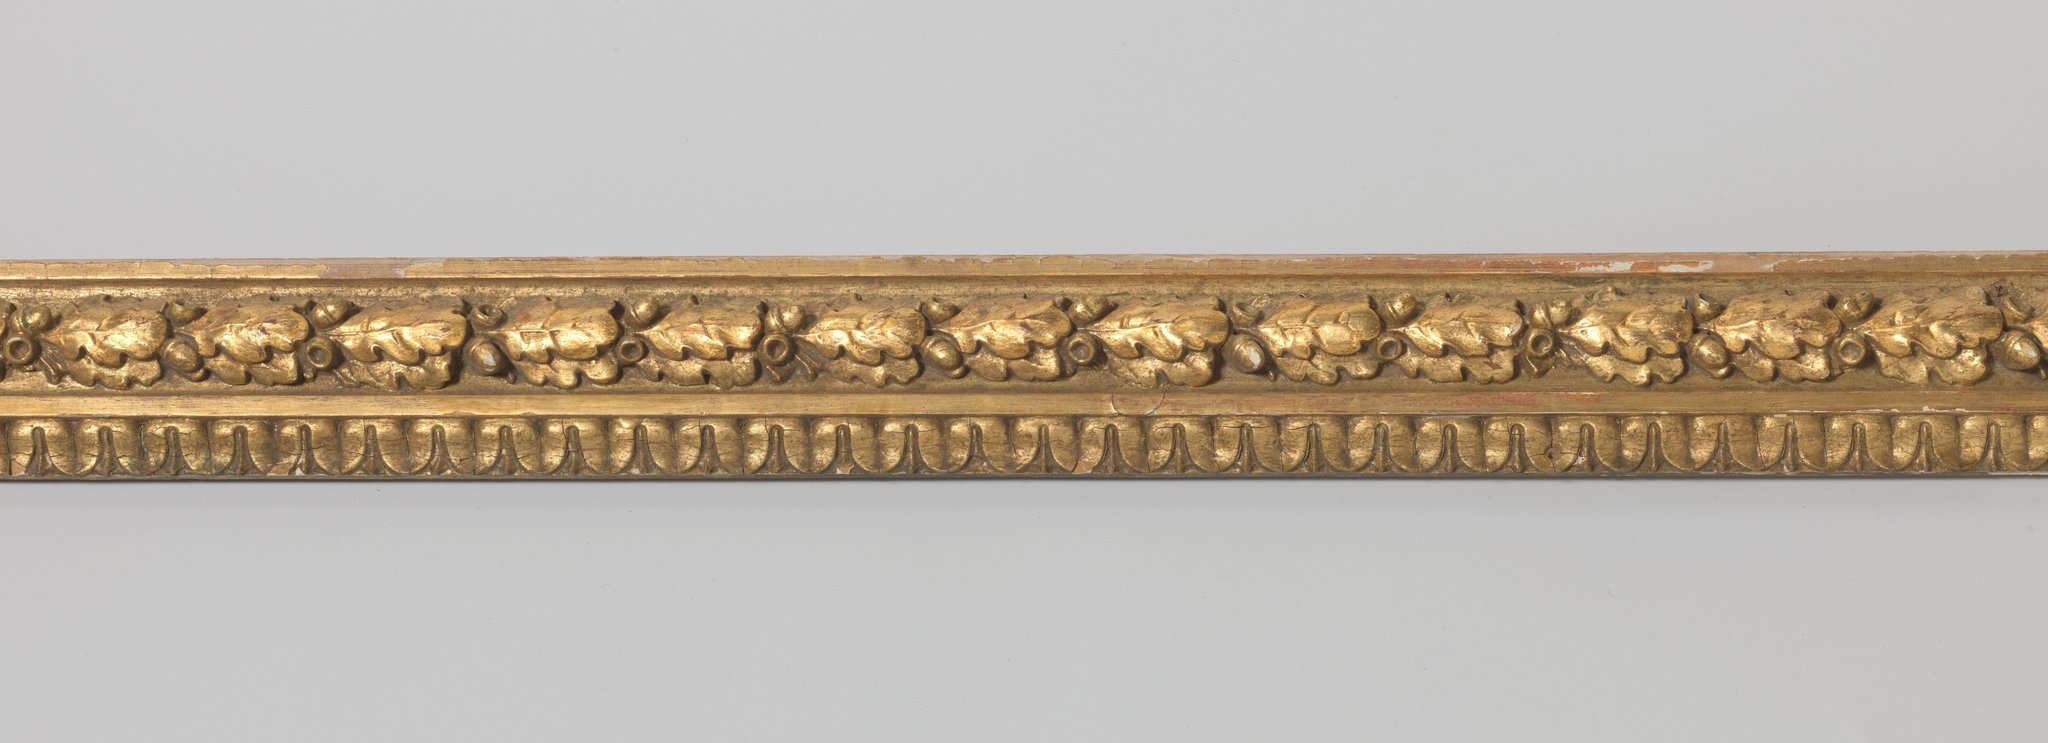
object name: frame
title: Lijstfragment: vergulde lijst met pâte-oramenten, rechterstijl.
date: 1700-1899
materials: gold leaf, wood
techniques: gilding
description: Vergulde lijst met eikenbladeren met eikeltjes. Lijstdeel, rechter stijl. Met achterop geschreven: 'Right, no. 2'.